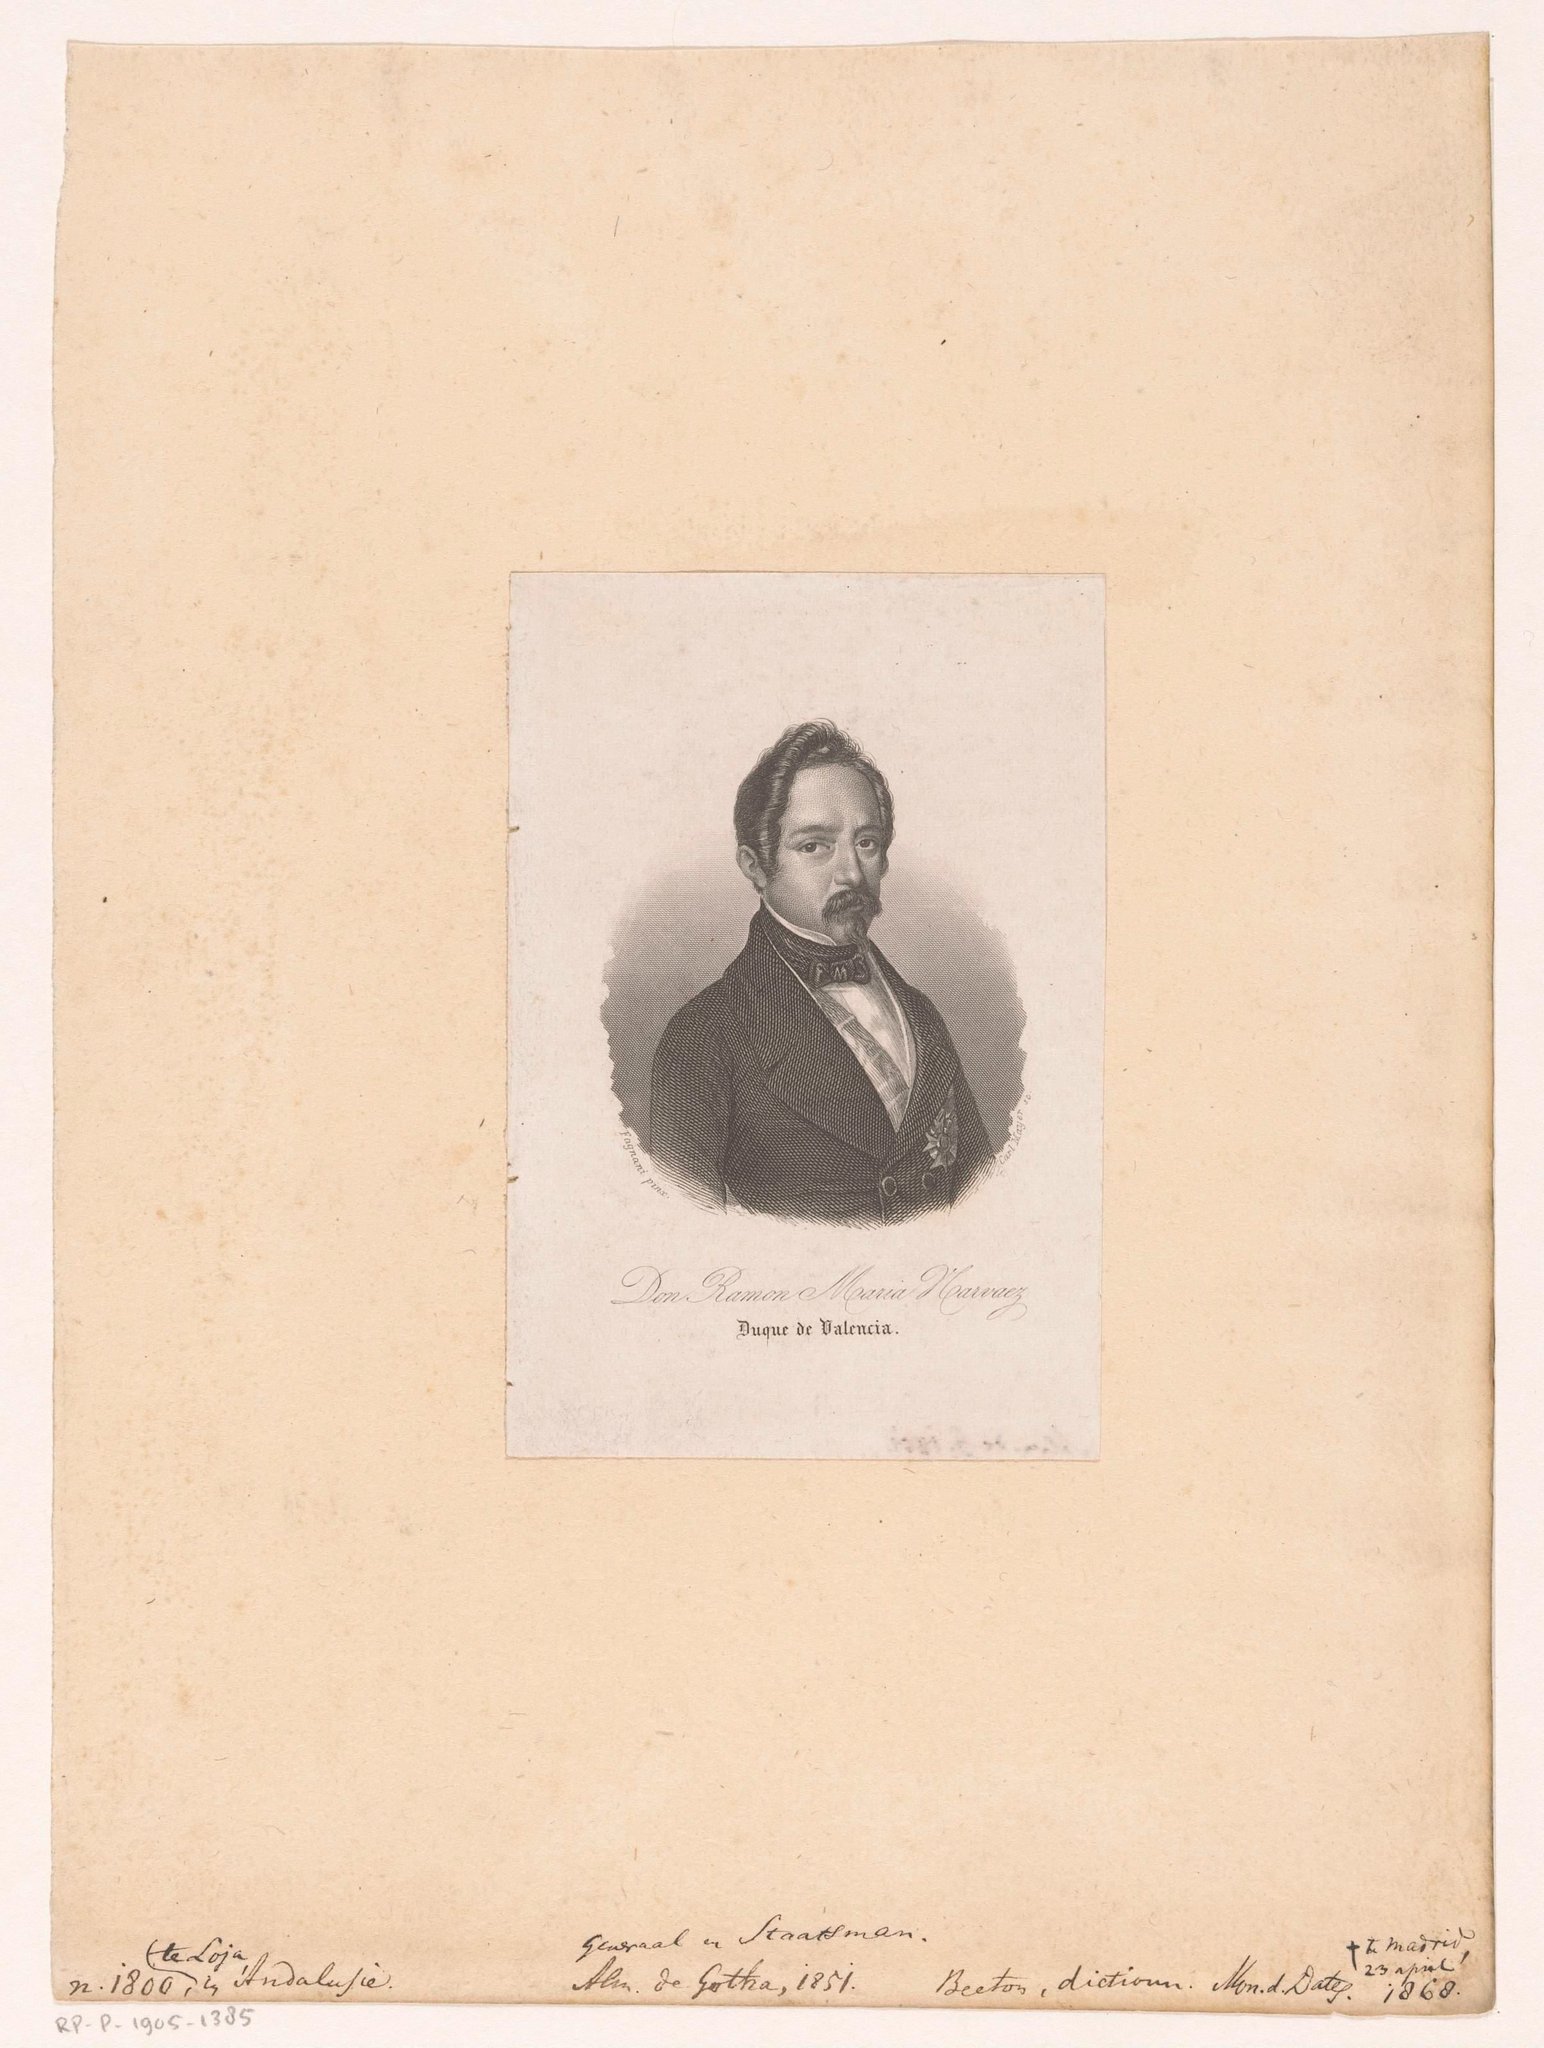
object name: print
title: Portret van Ramón María Narváez y Campos, hertog van Valencia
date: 1851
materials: paper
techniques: engraving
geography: nuremberg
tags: historical persons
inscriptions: collector's mark: Lugt 2228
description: Prent waarschijnlijk afkomstig uit de Almanach de Gotha, 1851.